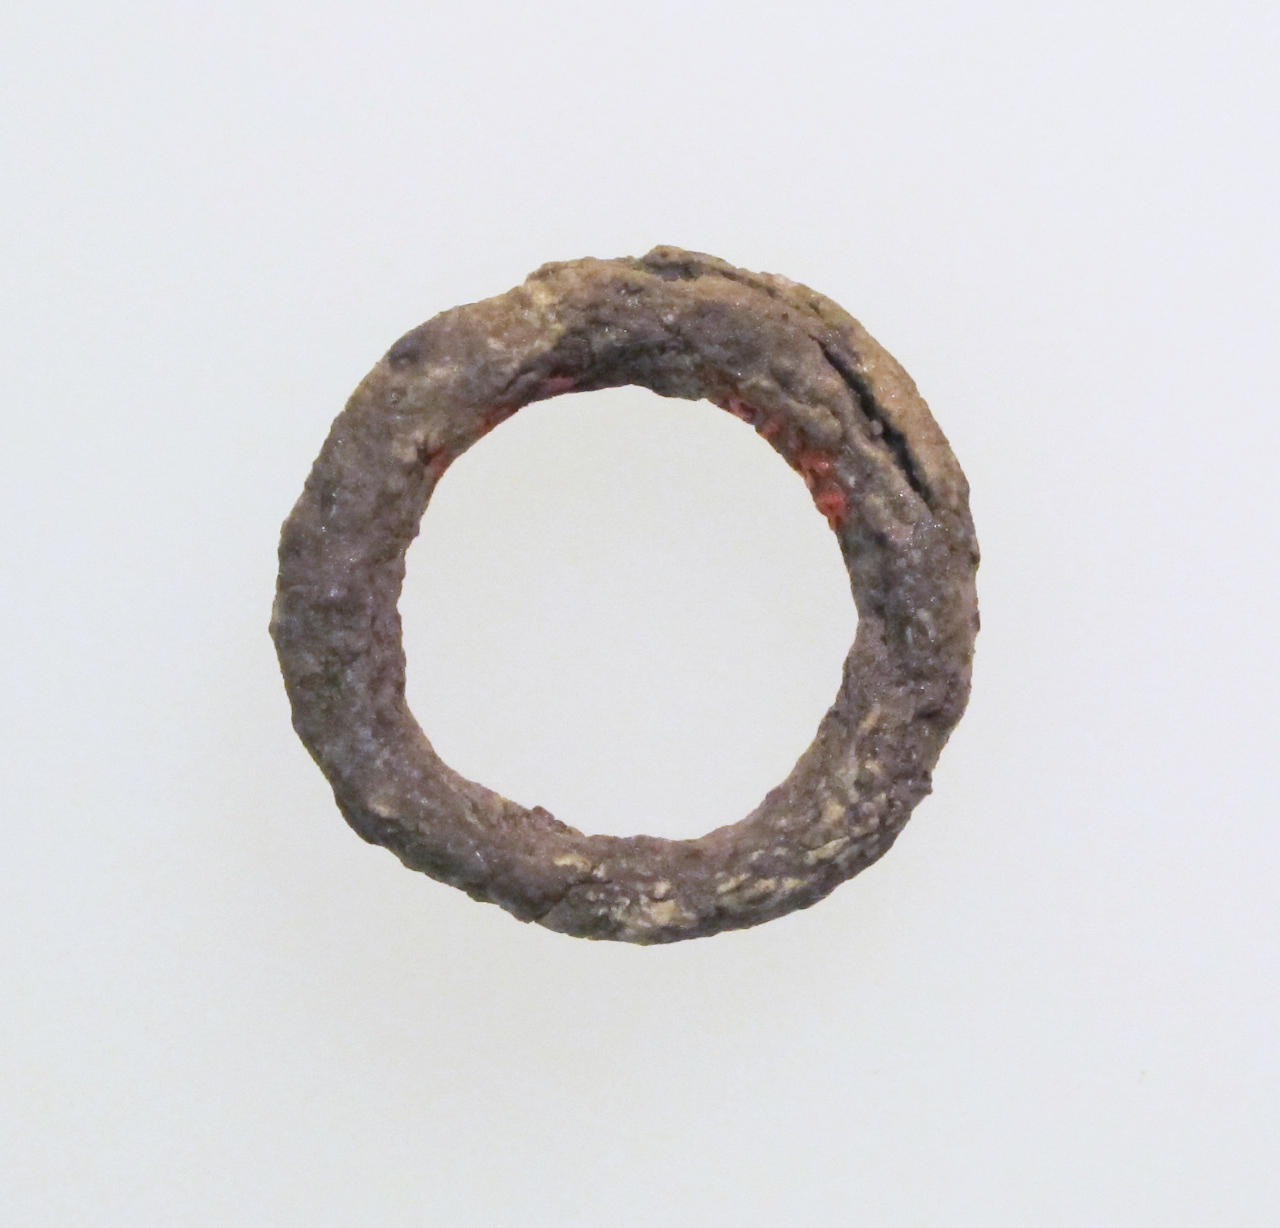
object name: ring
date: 7000 BCE-330 CE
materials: silver